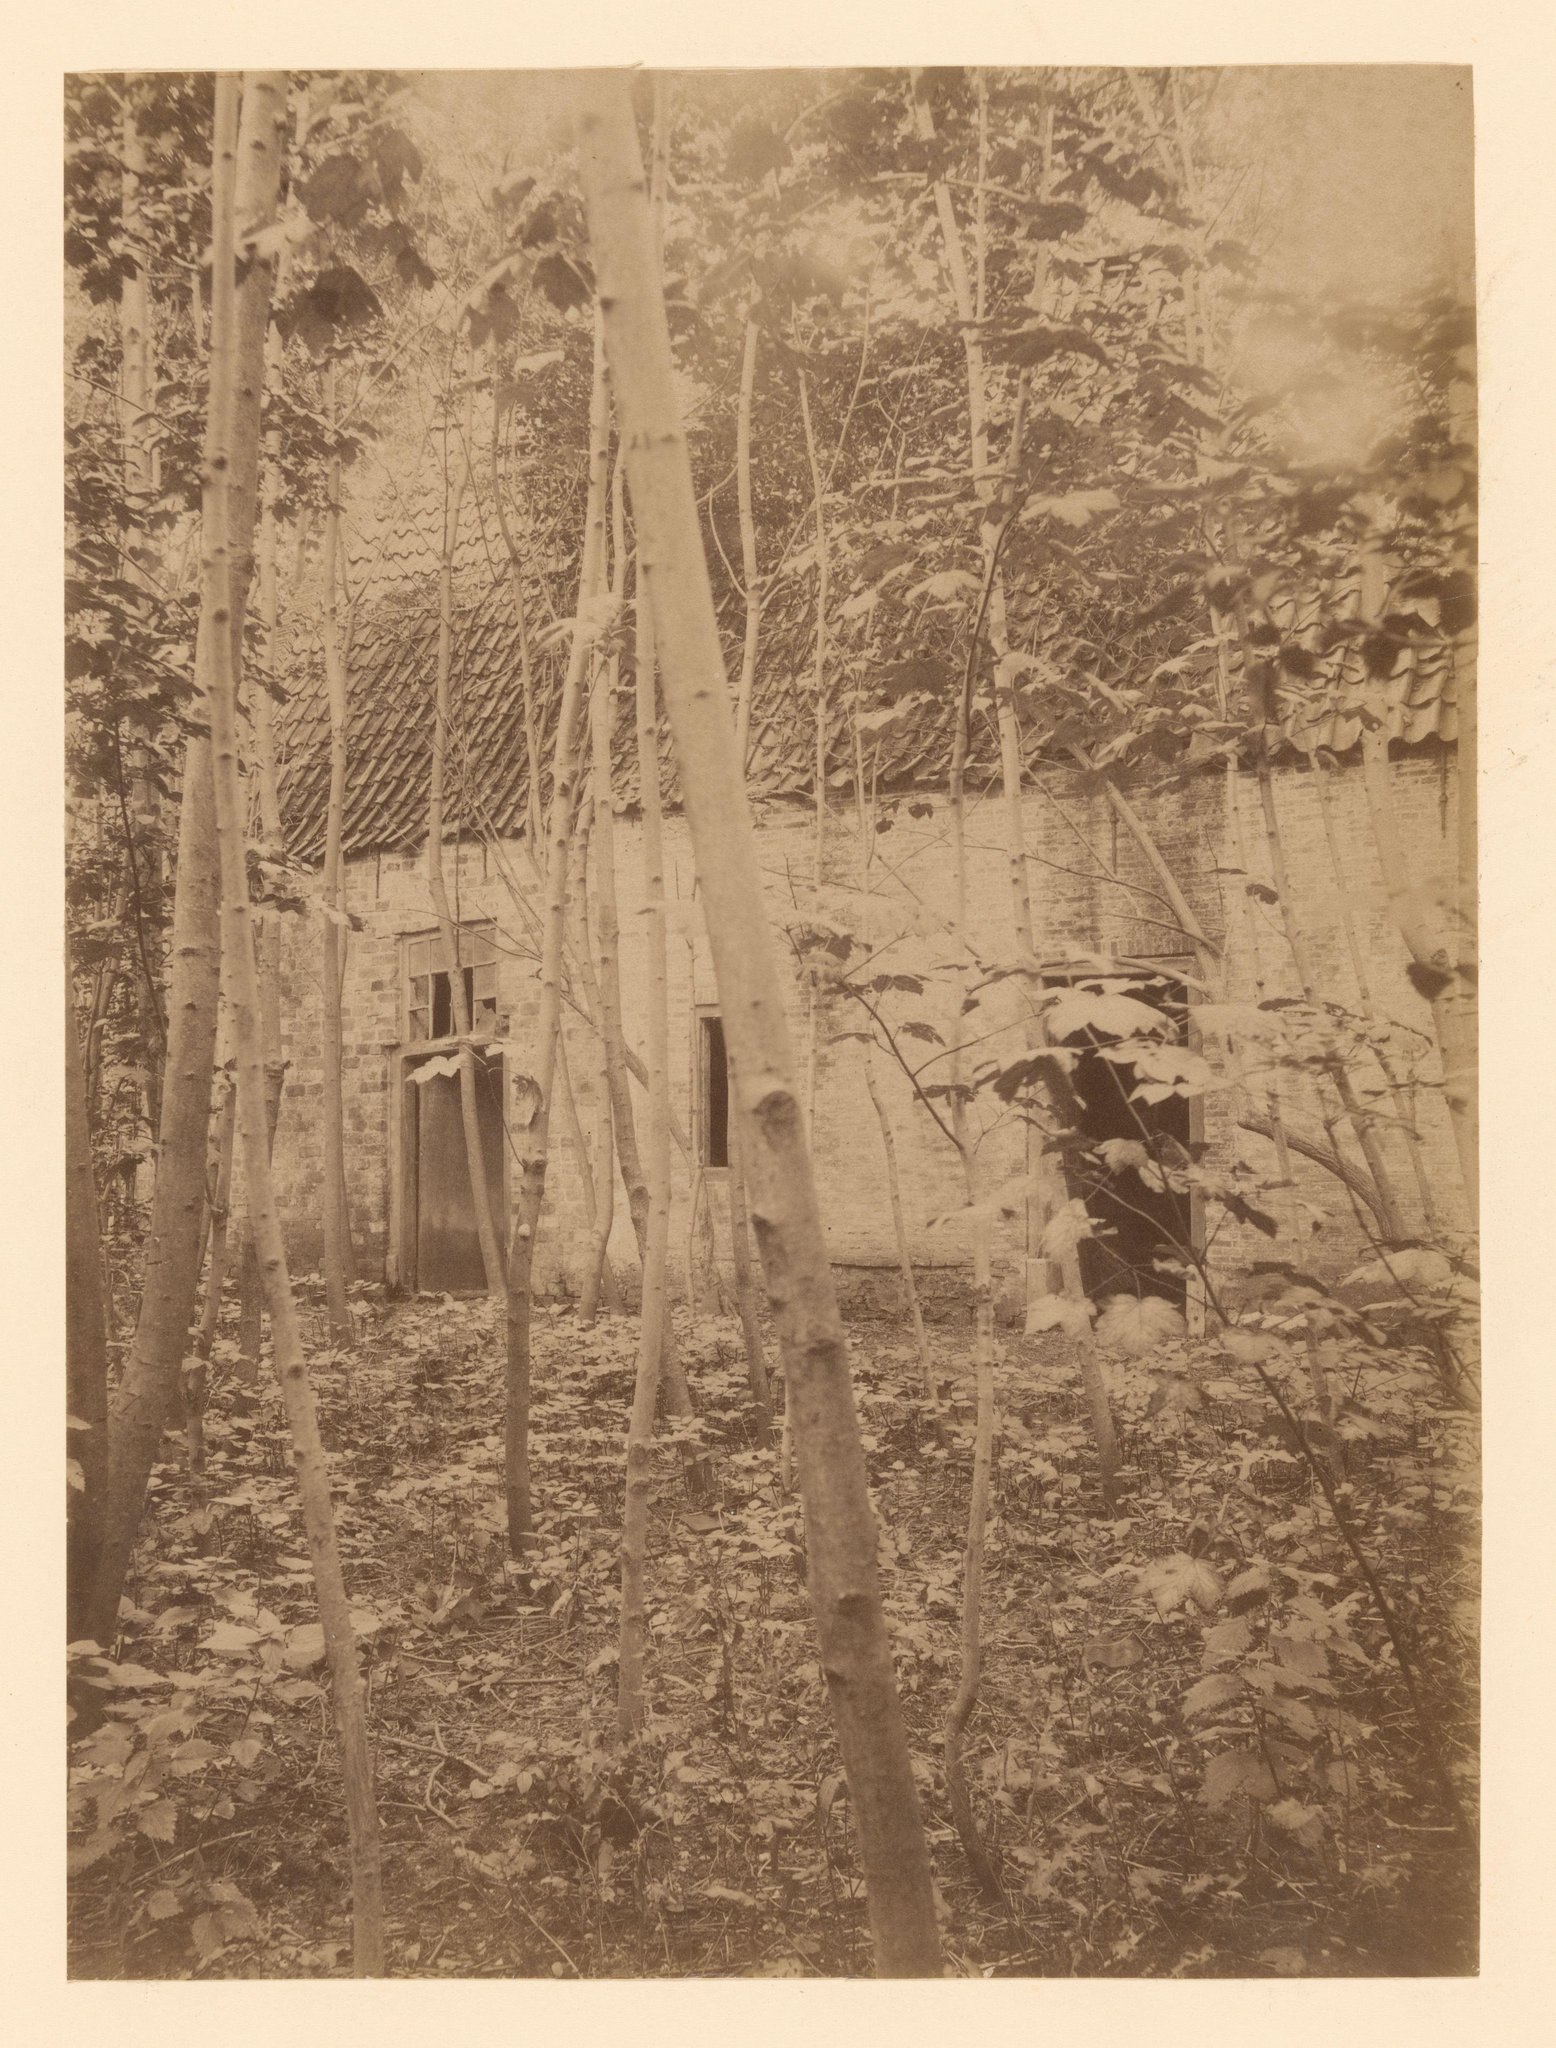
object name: photograph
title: Dekema State te Weidum tijdens de afbraak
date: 1902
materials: cardboard, photographic support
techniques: albumen print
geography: weidum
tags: villa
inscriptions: annotation: ‘Weidum/ Weidum/ Dekema/ gem. Baarderadeel’, annotation: ‘Weidum (Fr) / Dekema State / lijst 1902’